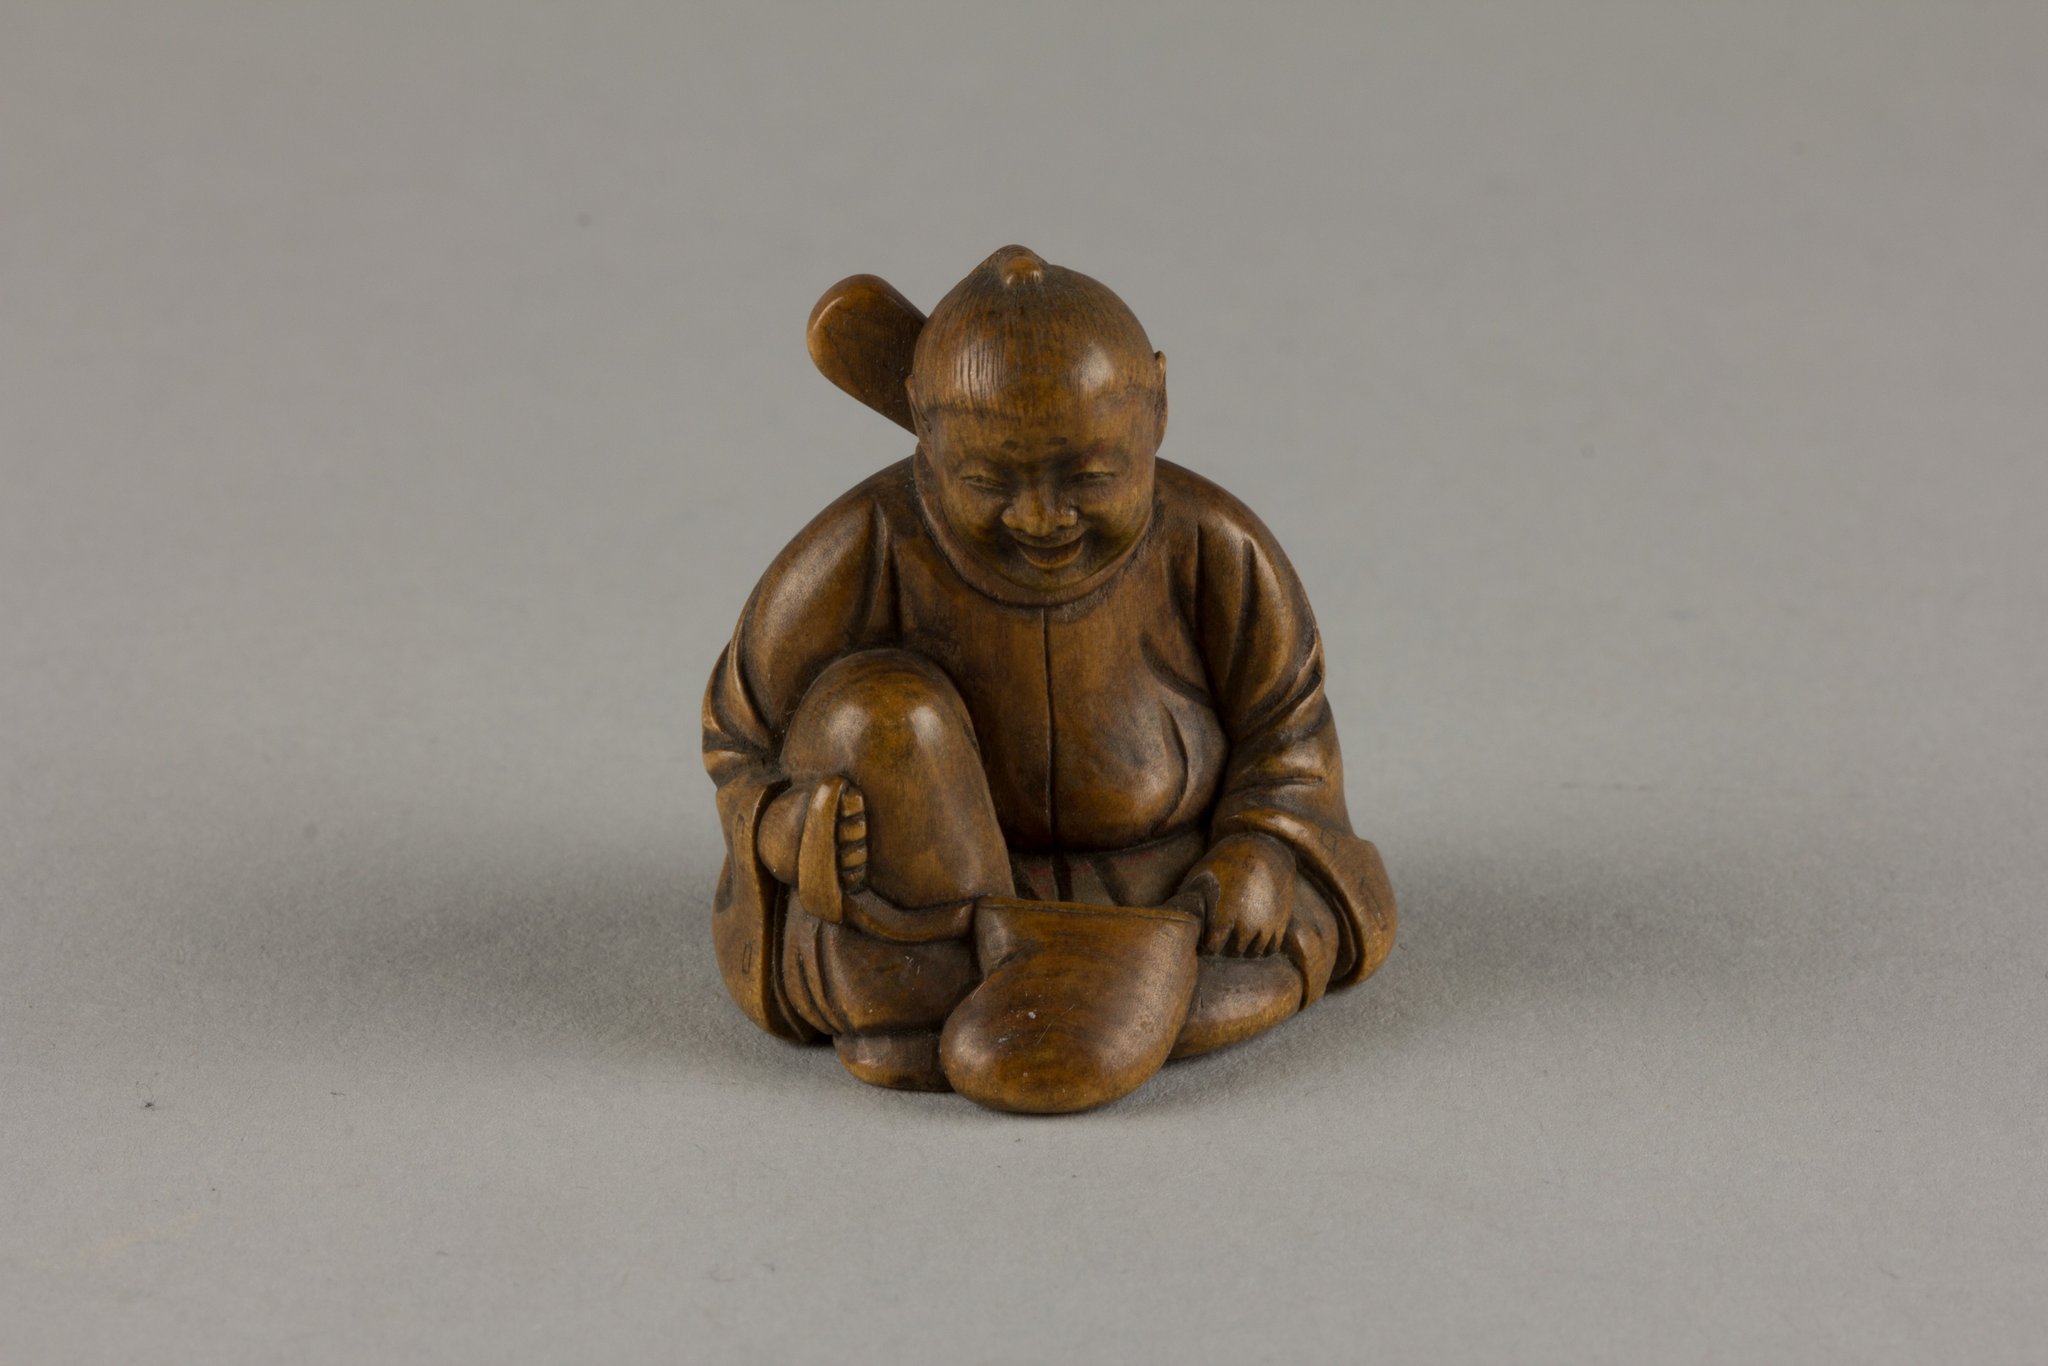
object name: netsuke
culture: japanese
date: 1801-1900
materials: wood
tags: human figures